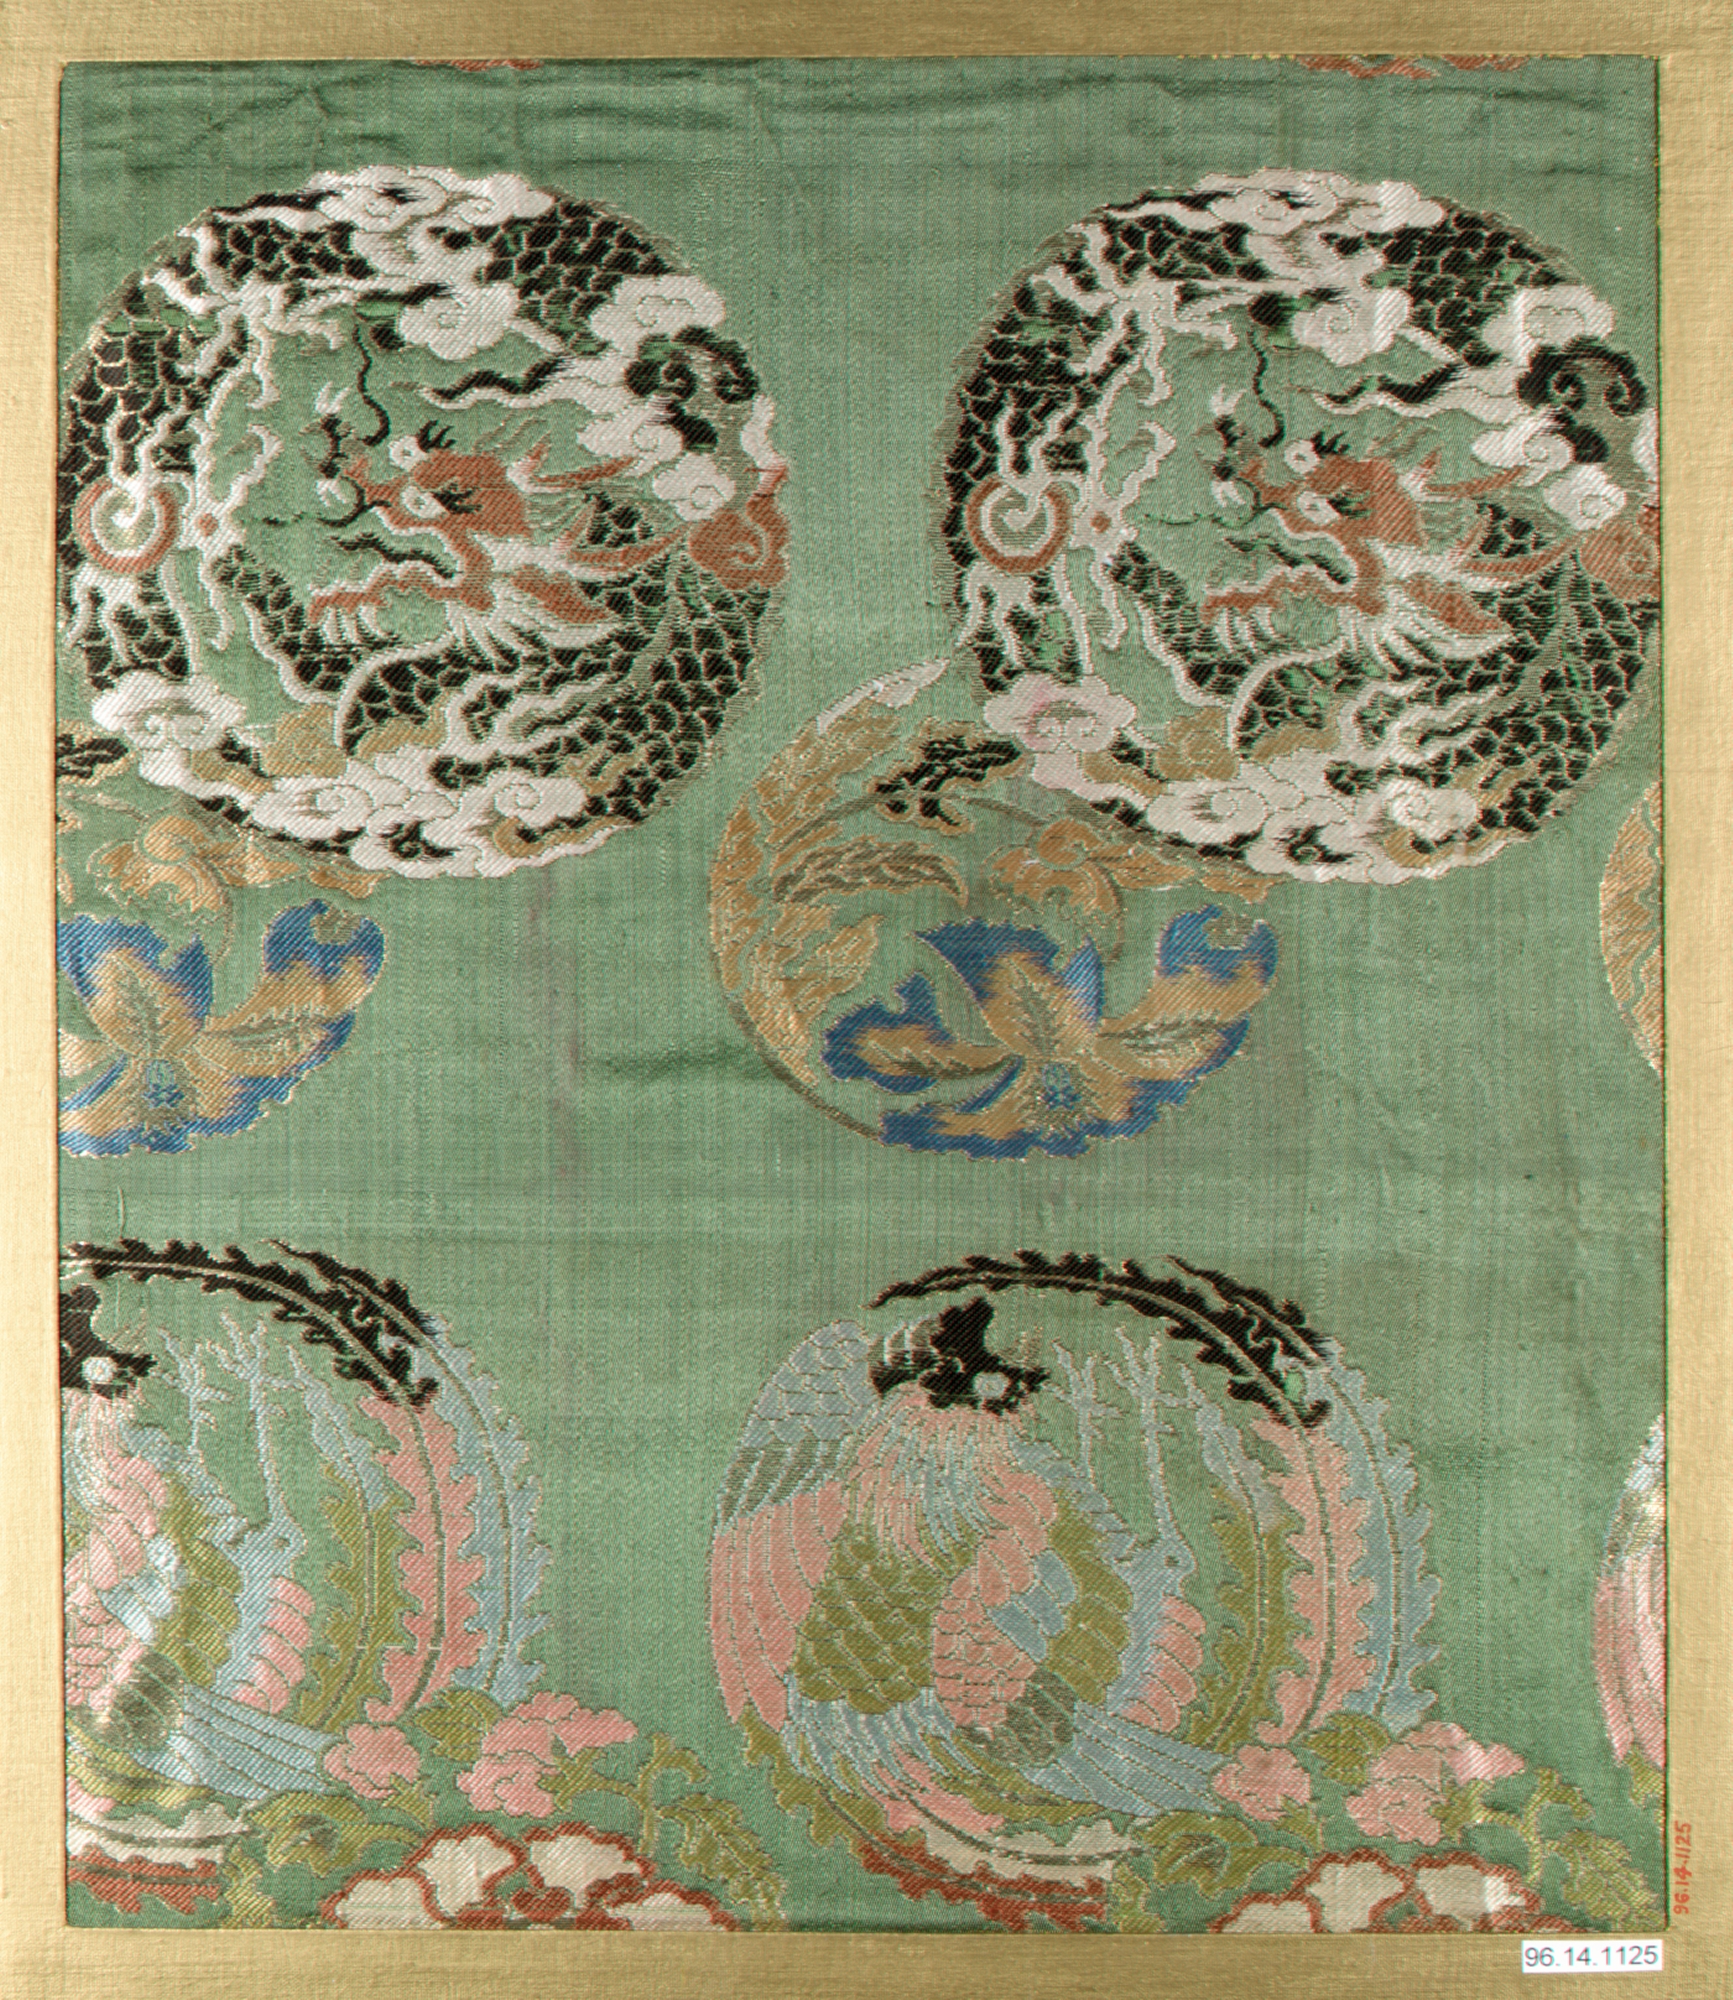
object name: piece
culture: japanese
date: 1701-1900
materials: silk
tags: dragons,phoenix